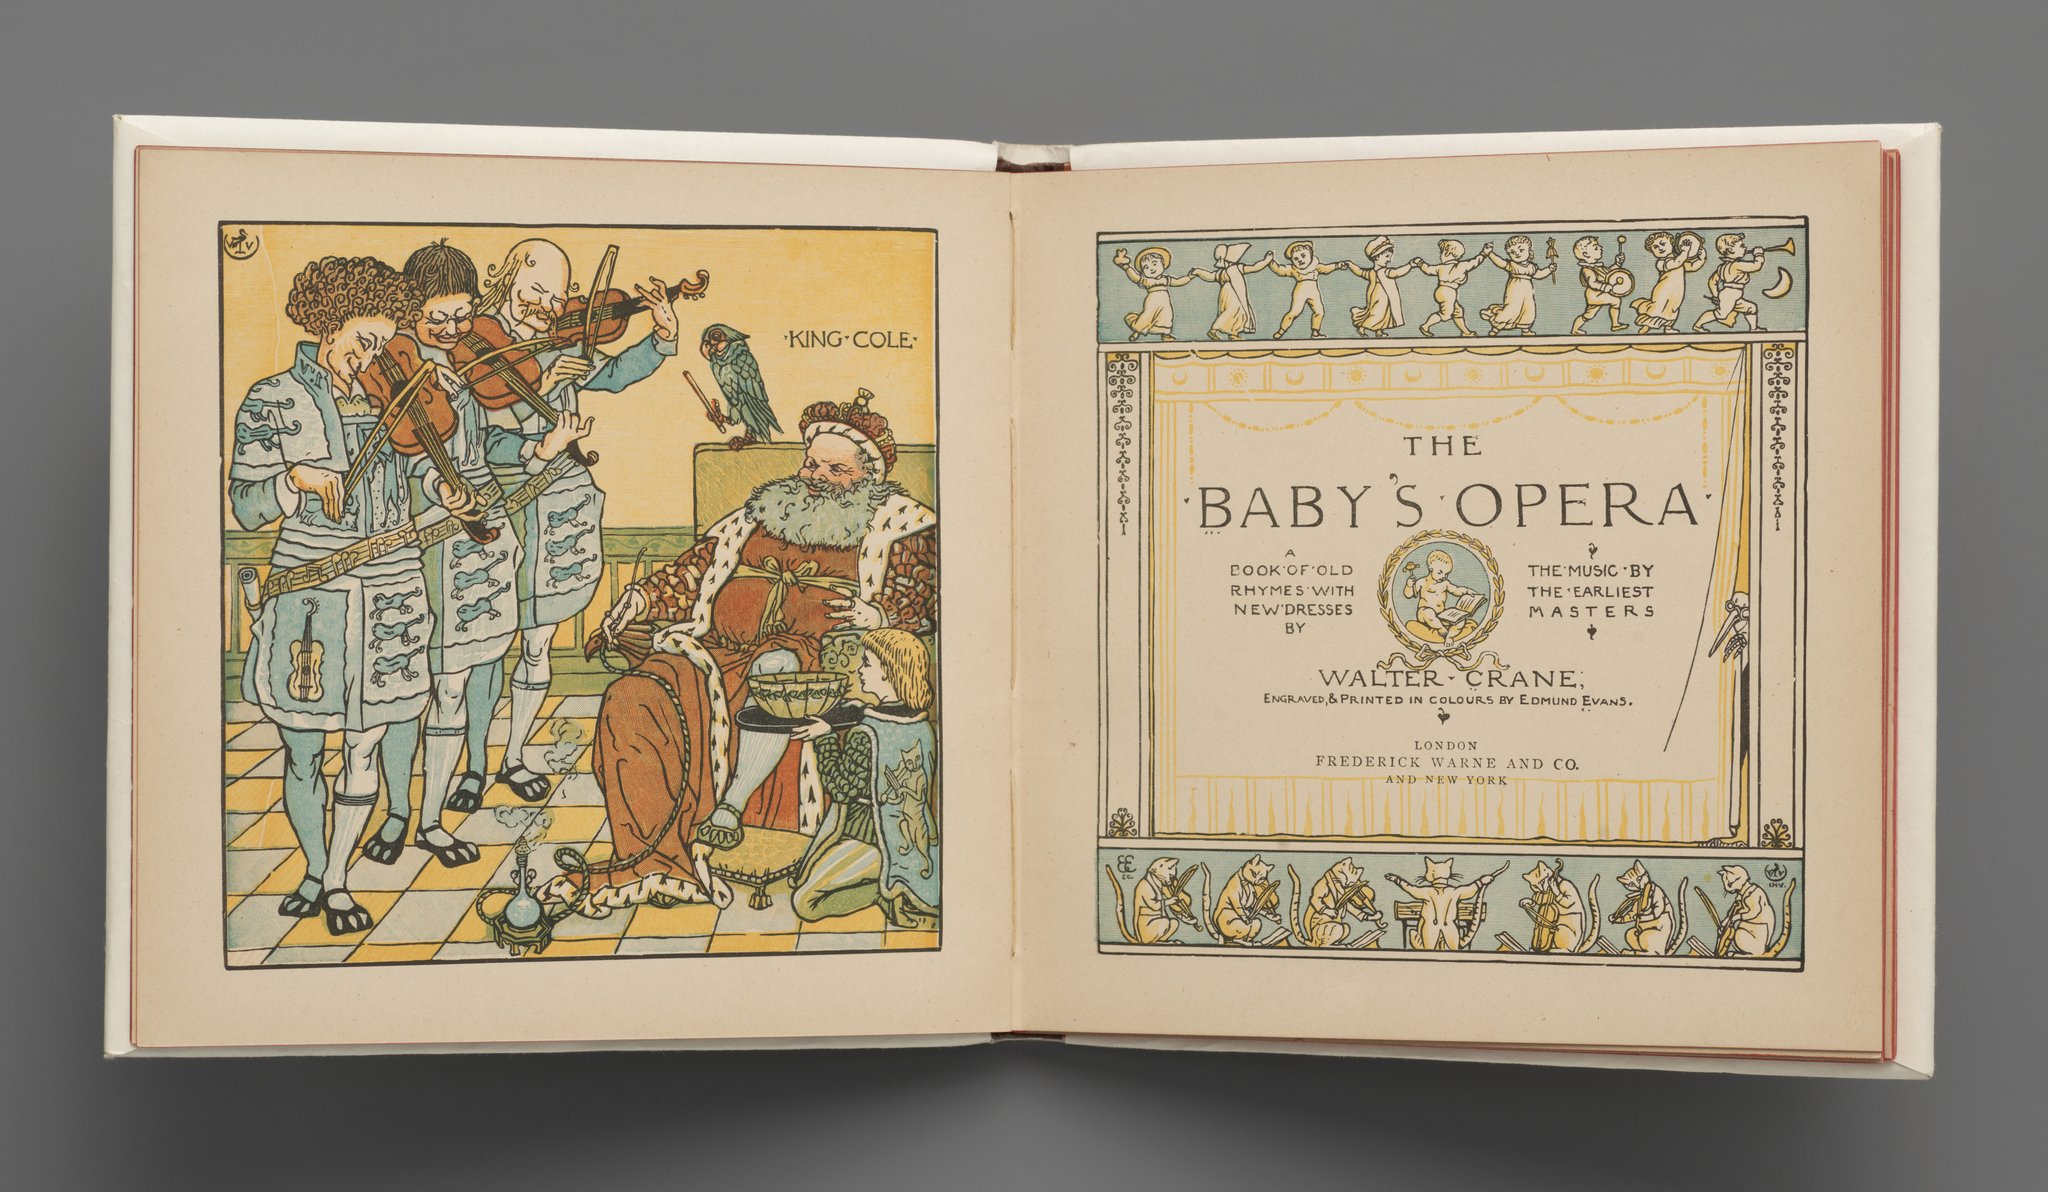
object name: book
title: The Baby's Opera, A Book of Old Rhymes with New Dresses... the Music by the Earliest Masters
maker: walter crane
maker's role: artist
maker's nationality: british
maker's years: 1845-1915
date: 1877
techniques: printing, engraving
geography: new york